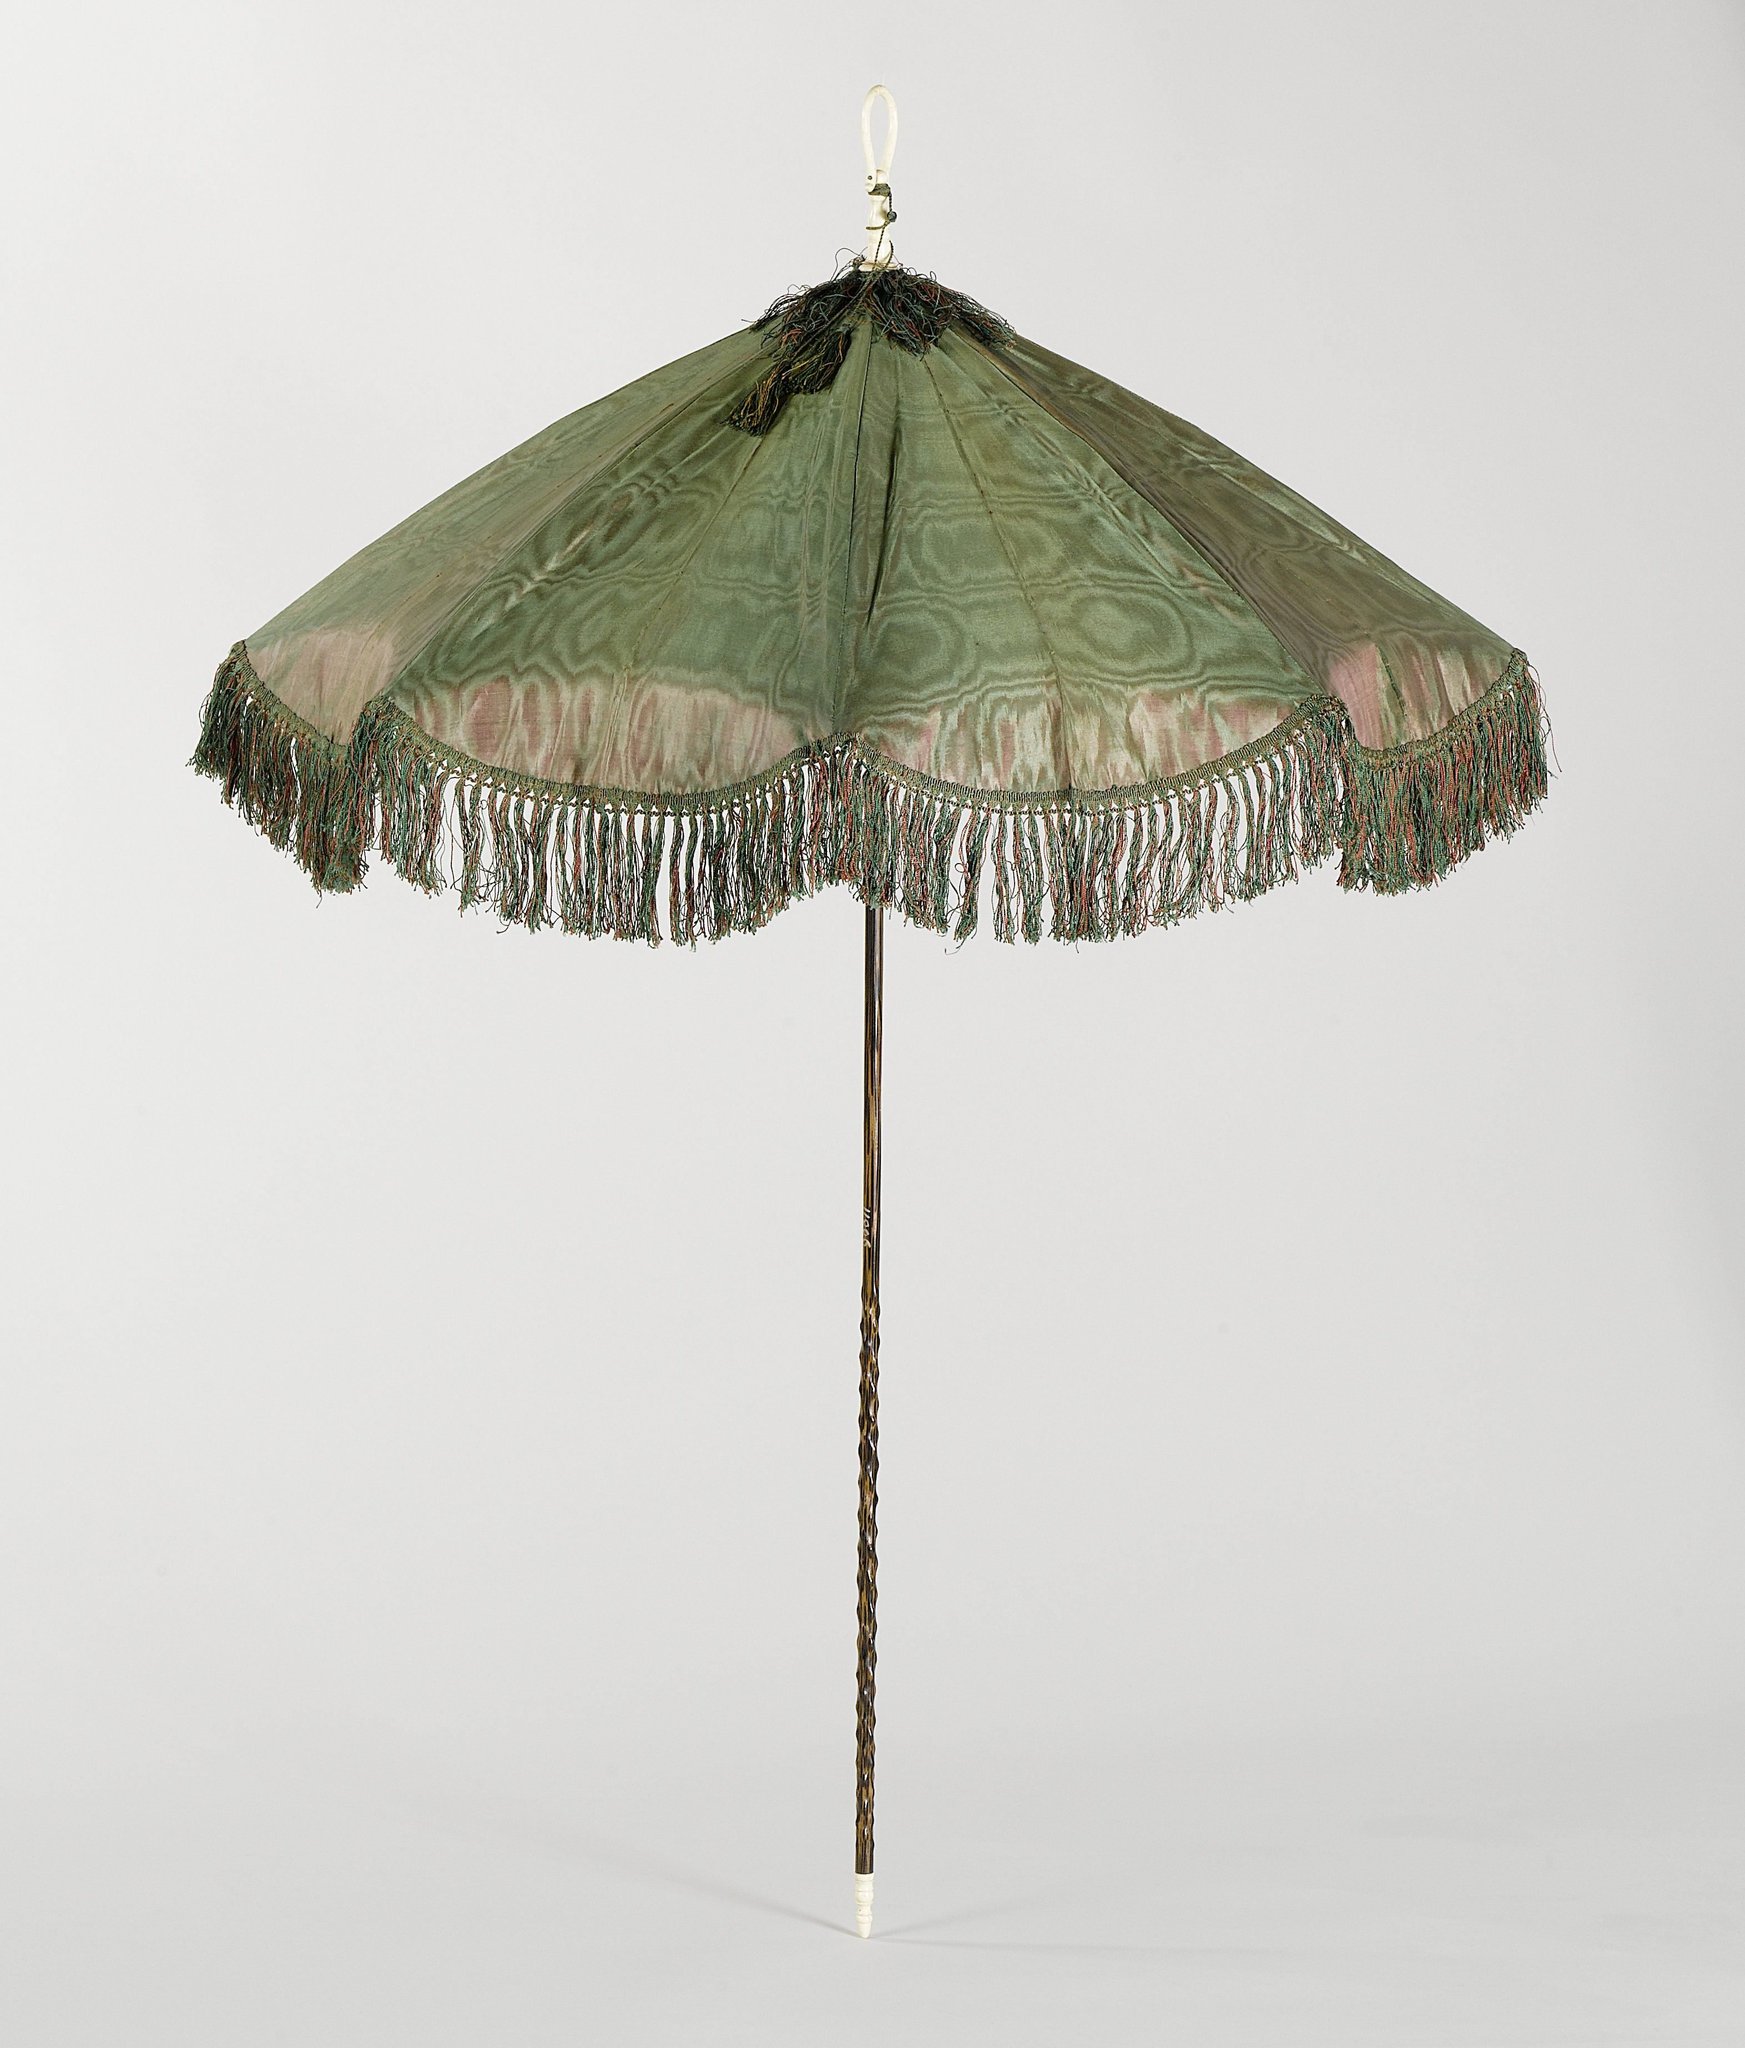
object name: parasol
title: Fringed parasol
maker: Anonymous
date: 1840-1860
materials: baleen, bone, glass, silk, wood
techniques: cutting, weave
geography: france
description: Parasol met dek van groene moiré en changeant zijde, bovenop en langs de rand afgezet met lange franje van groen en rood. Het dek is ongevoerd en telt acht walvisbaleinen. Lange smalle knoestige houten stok met zwarte accenten en aan de onderkant een punt van been. Bovenop een knop, waaraan een ring van been. Aan de knop twee groene kwasten een twee koorden, die kruislings door een groene kraal zijn gestoken.